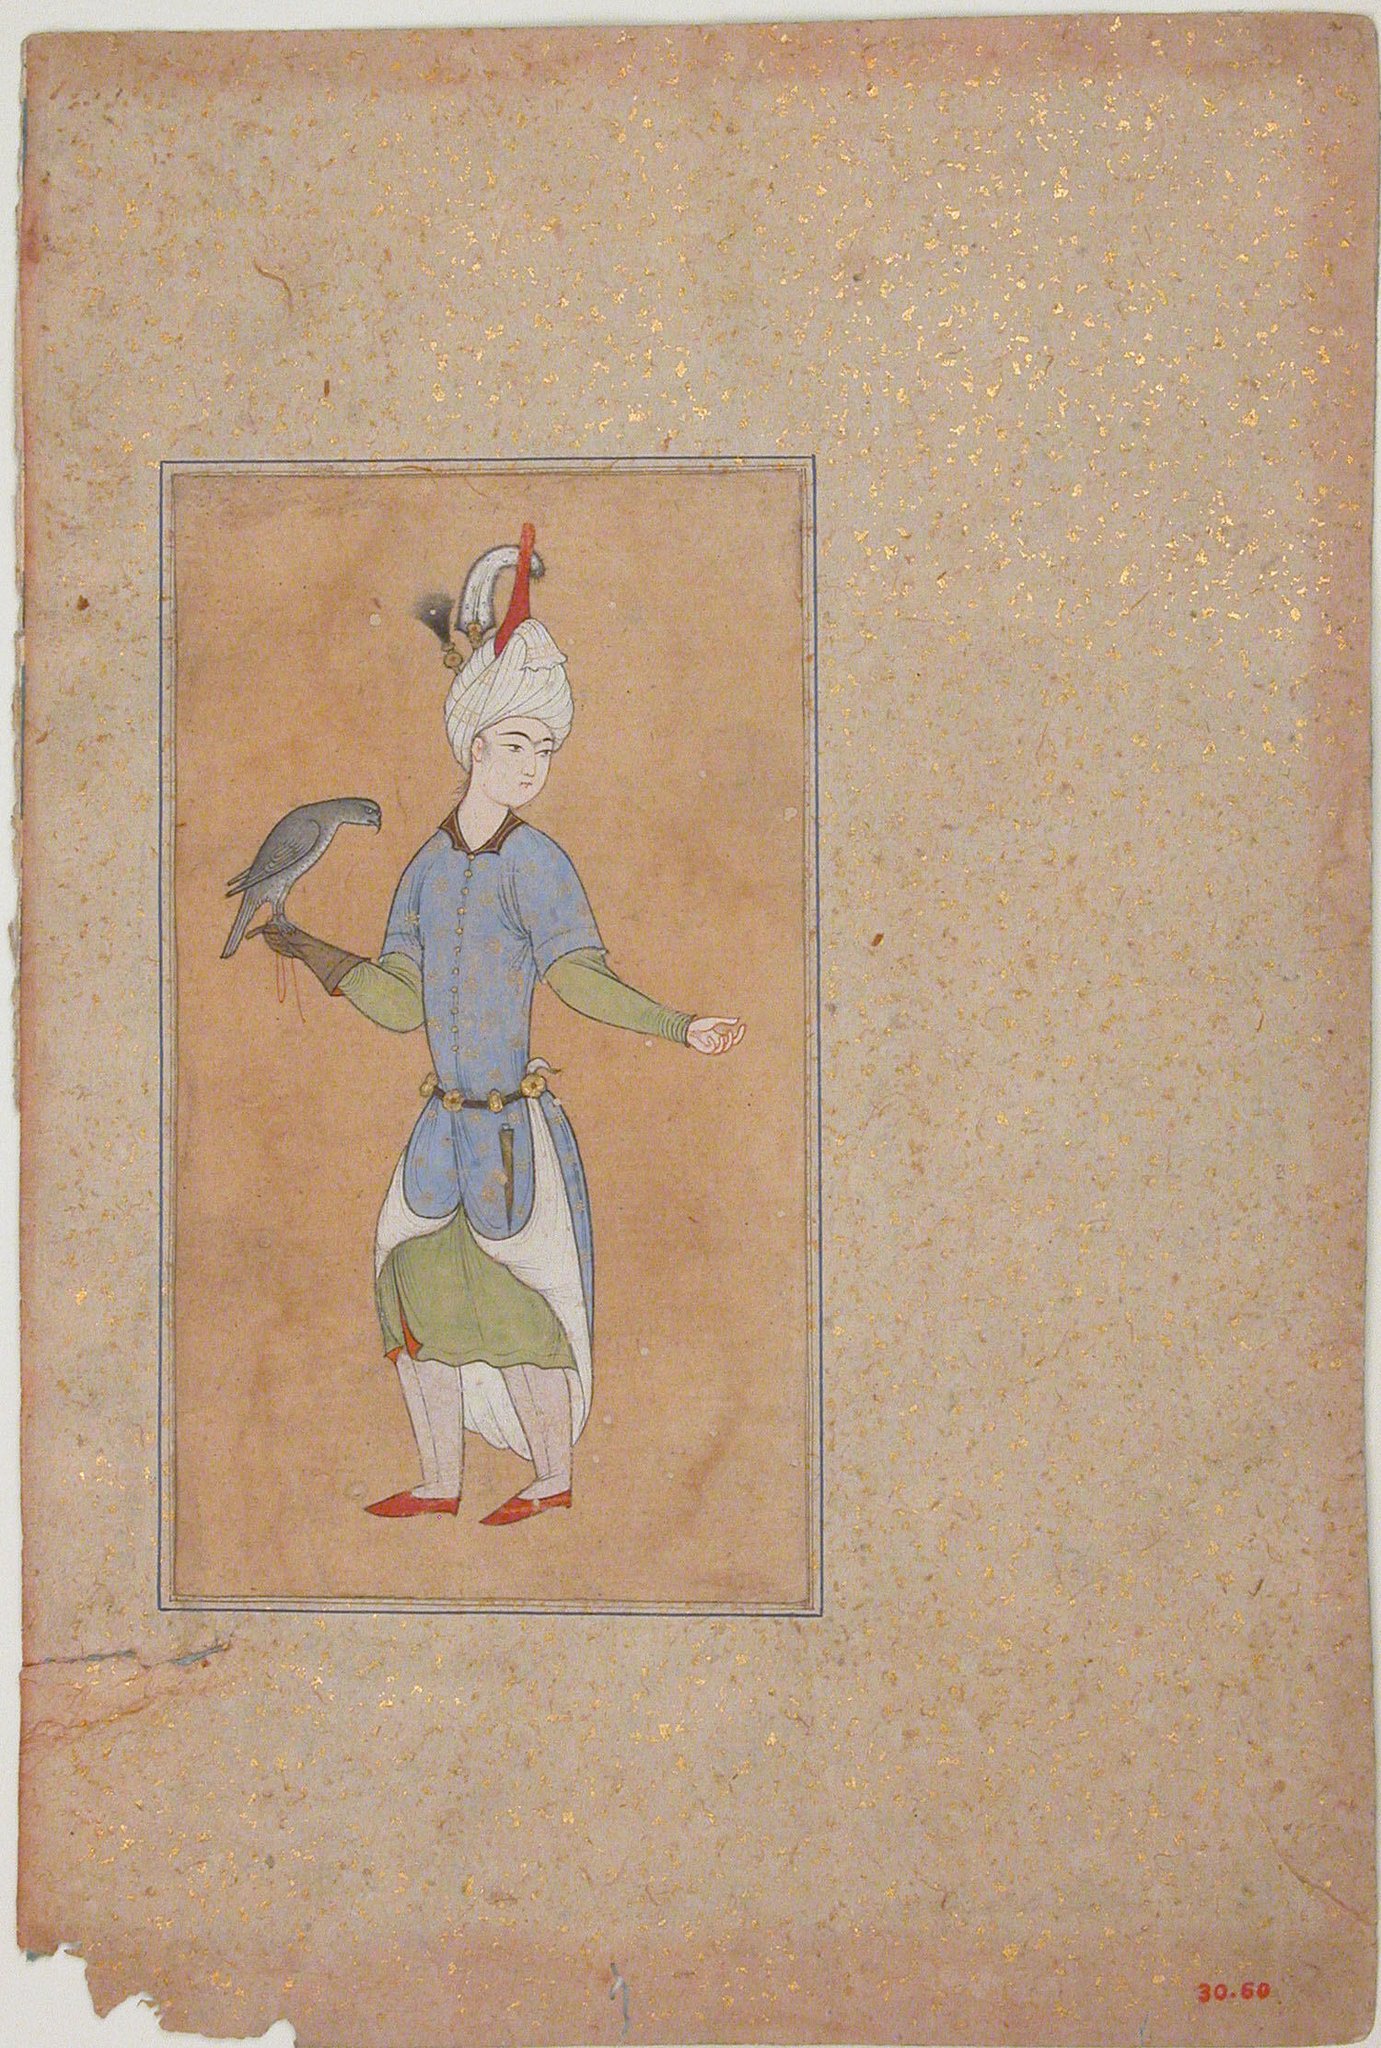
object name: album leaf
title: Portrait of a Noble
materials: gold, ink, paper, watercolor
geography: iran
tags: birds,men,portraits